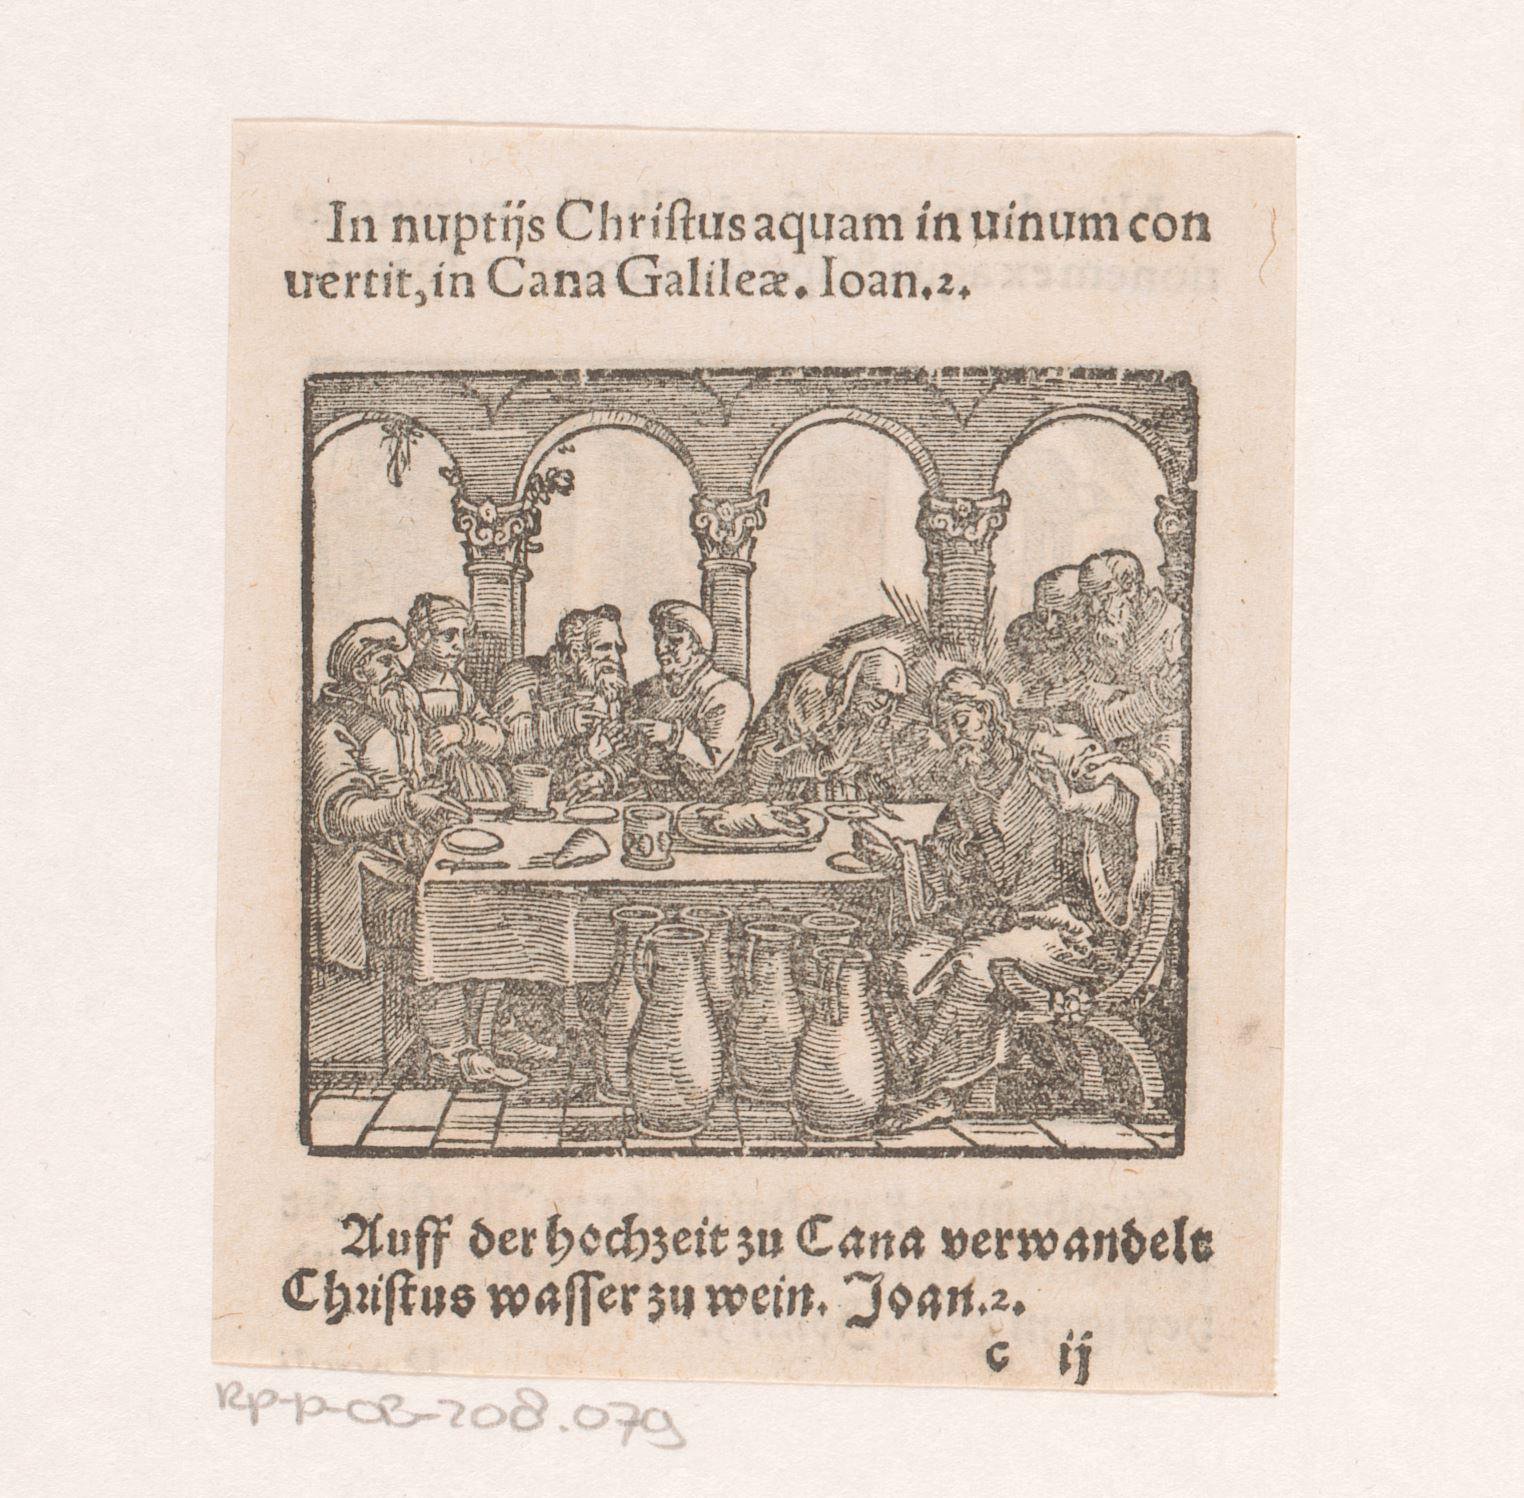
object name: print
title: Bruiloft te Kana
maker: Anonymous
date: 1600-1699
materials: paper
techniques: letterpress printing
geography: netherlands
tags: christ orders (six) jars to be filled with water ~ marriage-feast at cana, the marriage-feast at cana (john 2:1-11)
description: Op de bruiloft te Kana beveelt Christus zes kruiken met water te vullen. Vervolgens verandert hij het water in wijn.